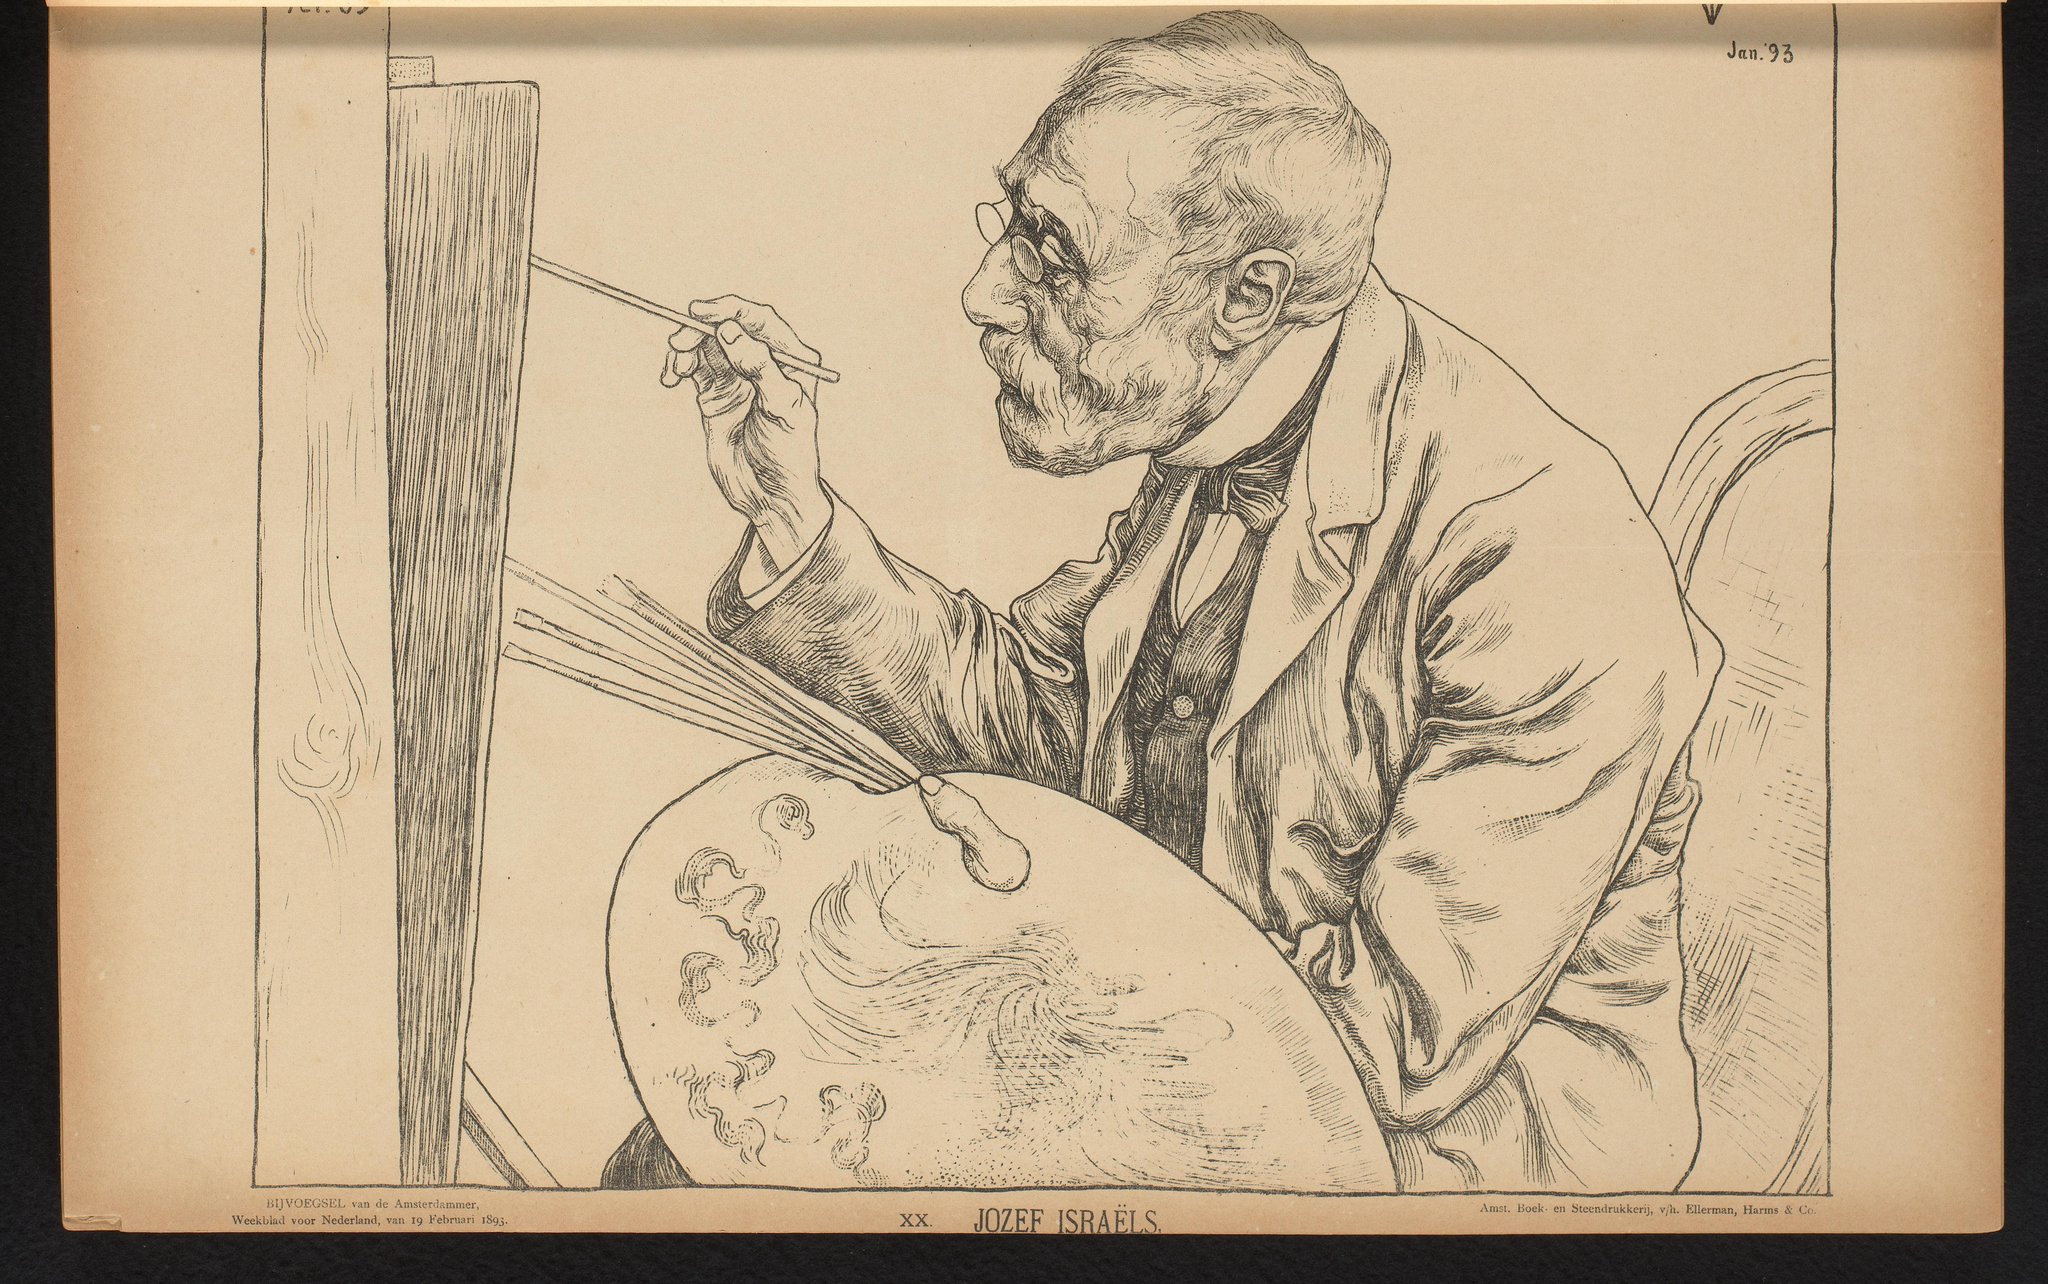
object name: print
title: Jozef Israëls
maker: jan veth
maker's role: designer, draughtsman, painter, print maker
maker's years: 1864-1925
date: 1893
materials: paper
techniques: lithograph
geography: amsterdam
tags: the hague, painter, print maker, draughtsman, jozef israëls, historical persons, portrait, self-portrait of painter, painter at work, in his studio, portrait, self-portrait of artist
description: Portret van de schilder Jozef Israëls, schilderend met palet in de hand. In de serie 'Bekende Tijdgenooten', nr. XX.